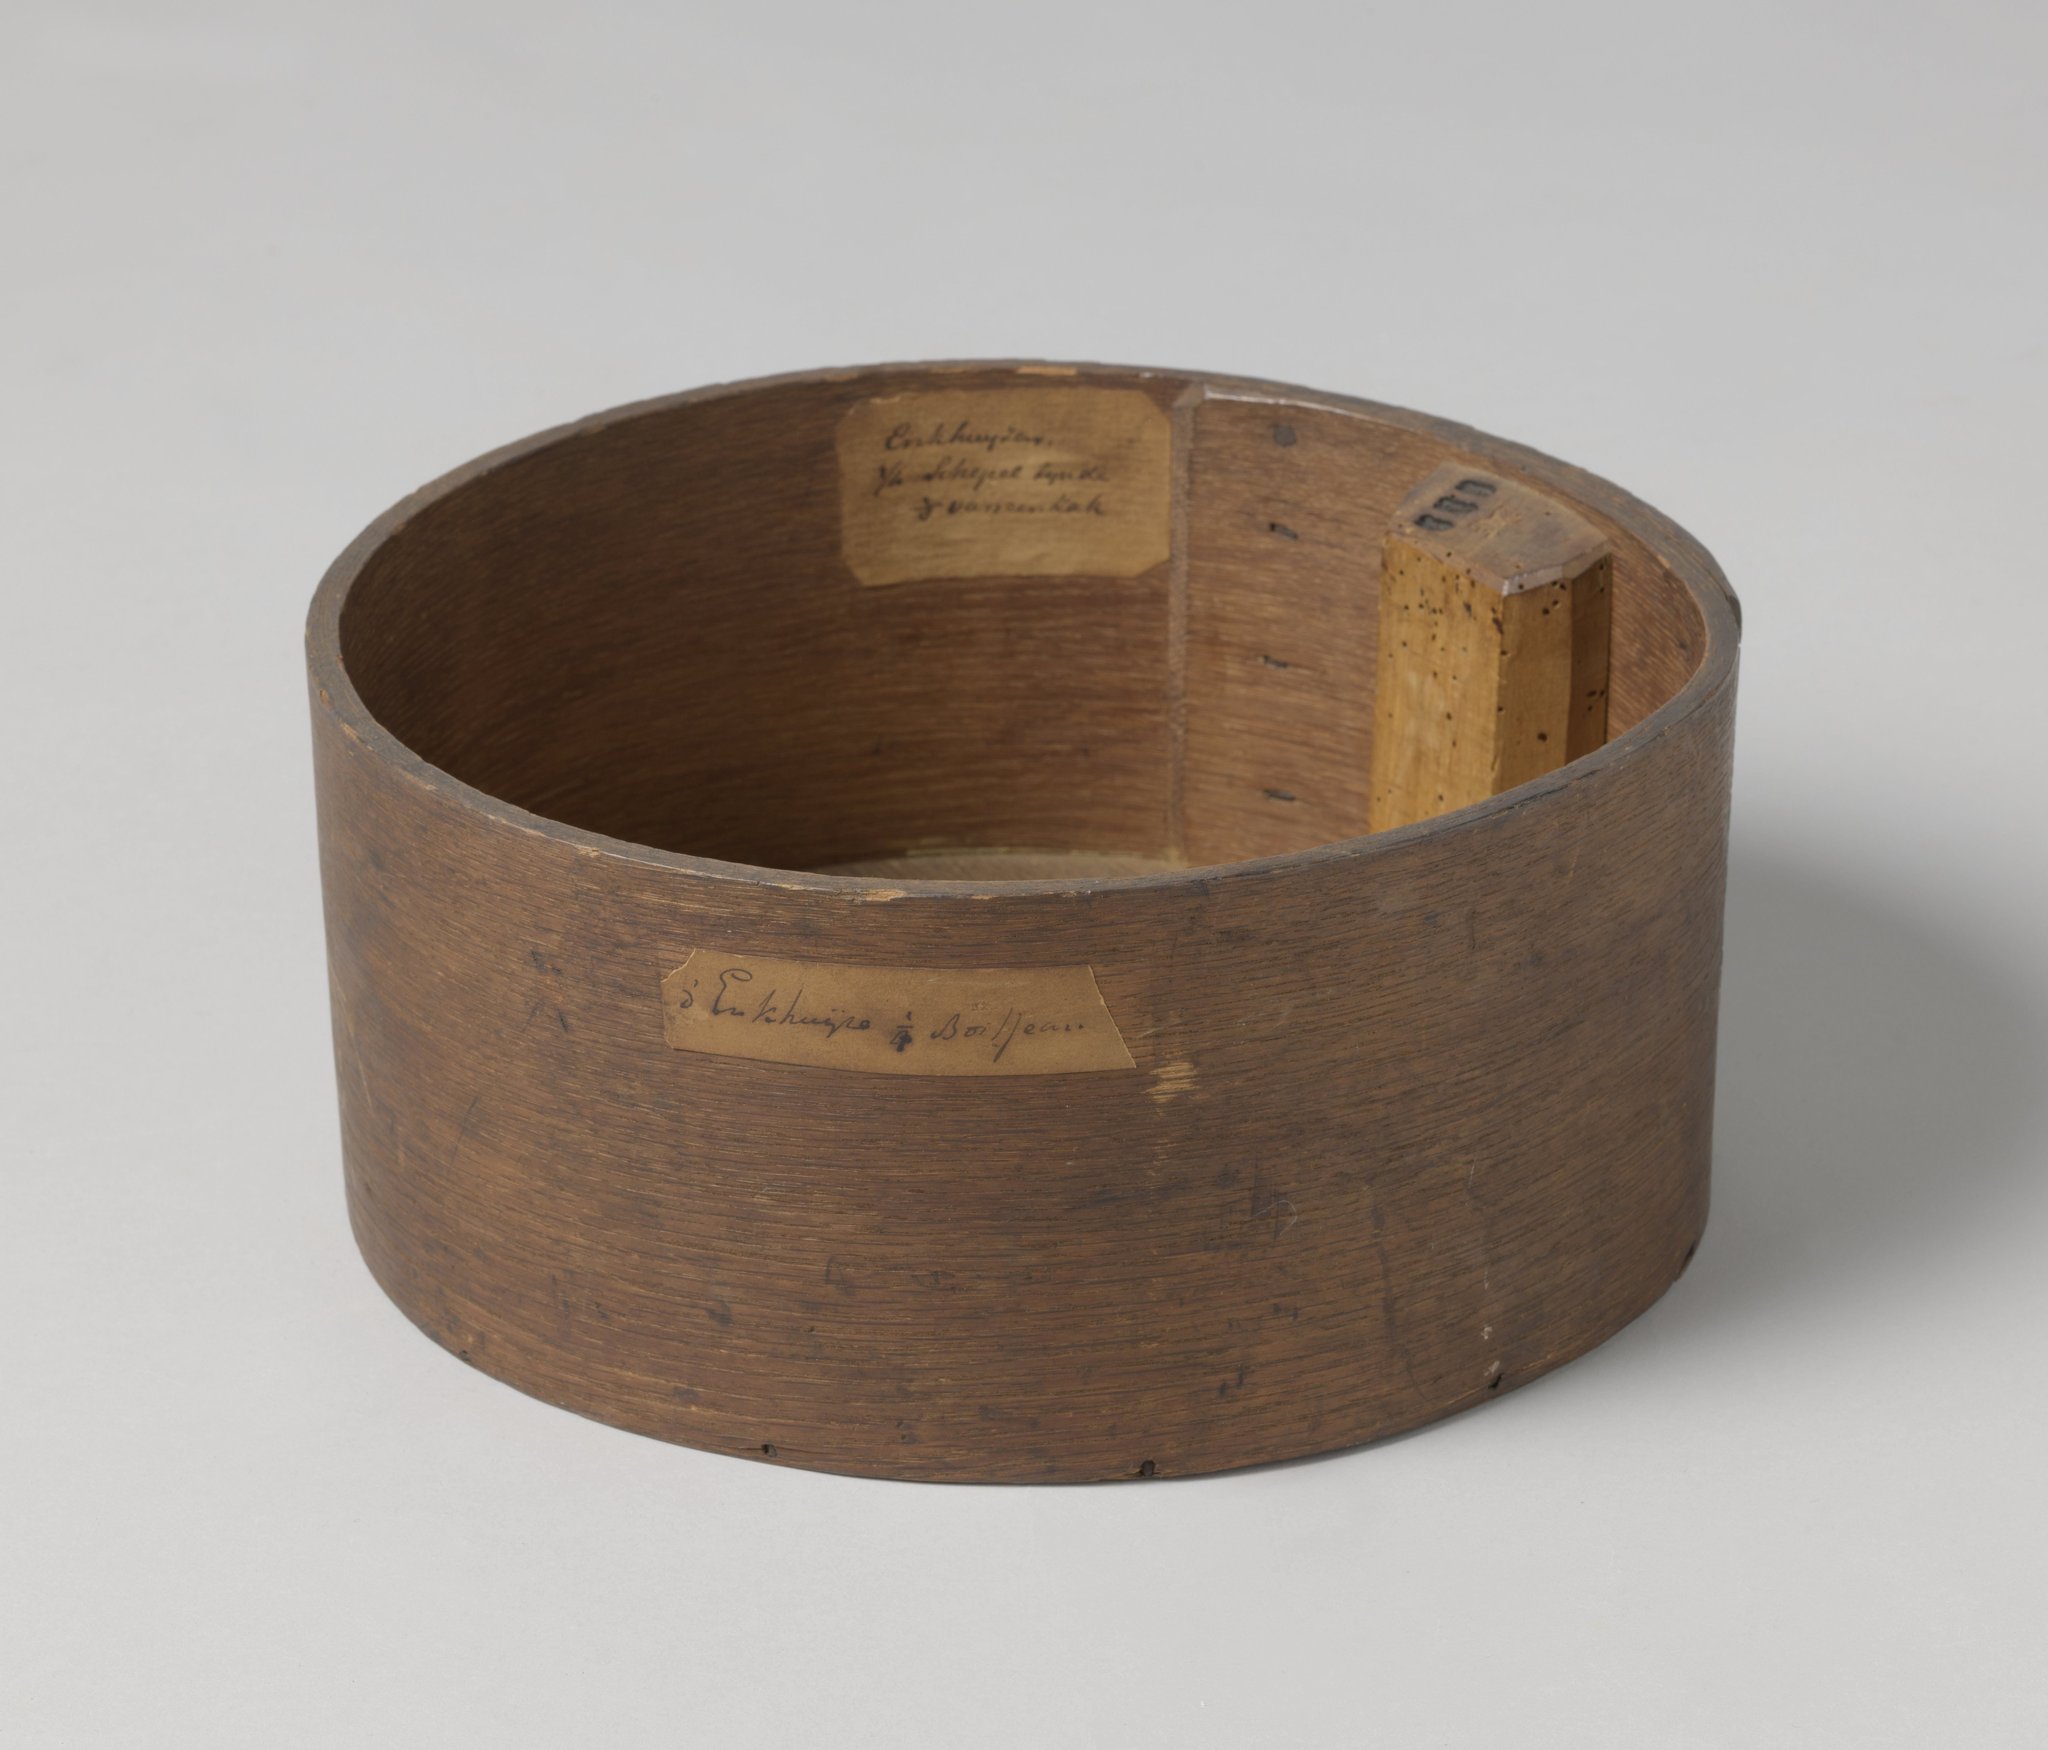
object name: inhoudsmaat droge waren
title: 1/4 Boisseau uit Enkhuizen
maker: Anonymous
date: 1800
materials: wood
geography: enkhuizen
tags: enkhuizen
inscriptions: : ‘1800’, inscription: ‘Enkhuyzen 1/4 Schepel zynde 1/8 van een Zak / genummerd 38’, title: ‘d'Enkhuijze 1/4 Boisseau’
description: Spanen inhoudsmaat droge waren van 1/4 Boisseau met blok aan de binnenzijde, v.z.v. merk en etiketten.